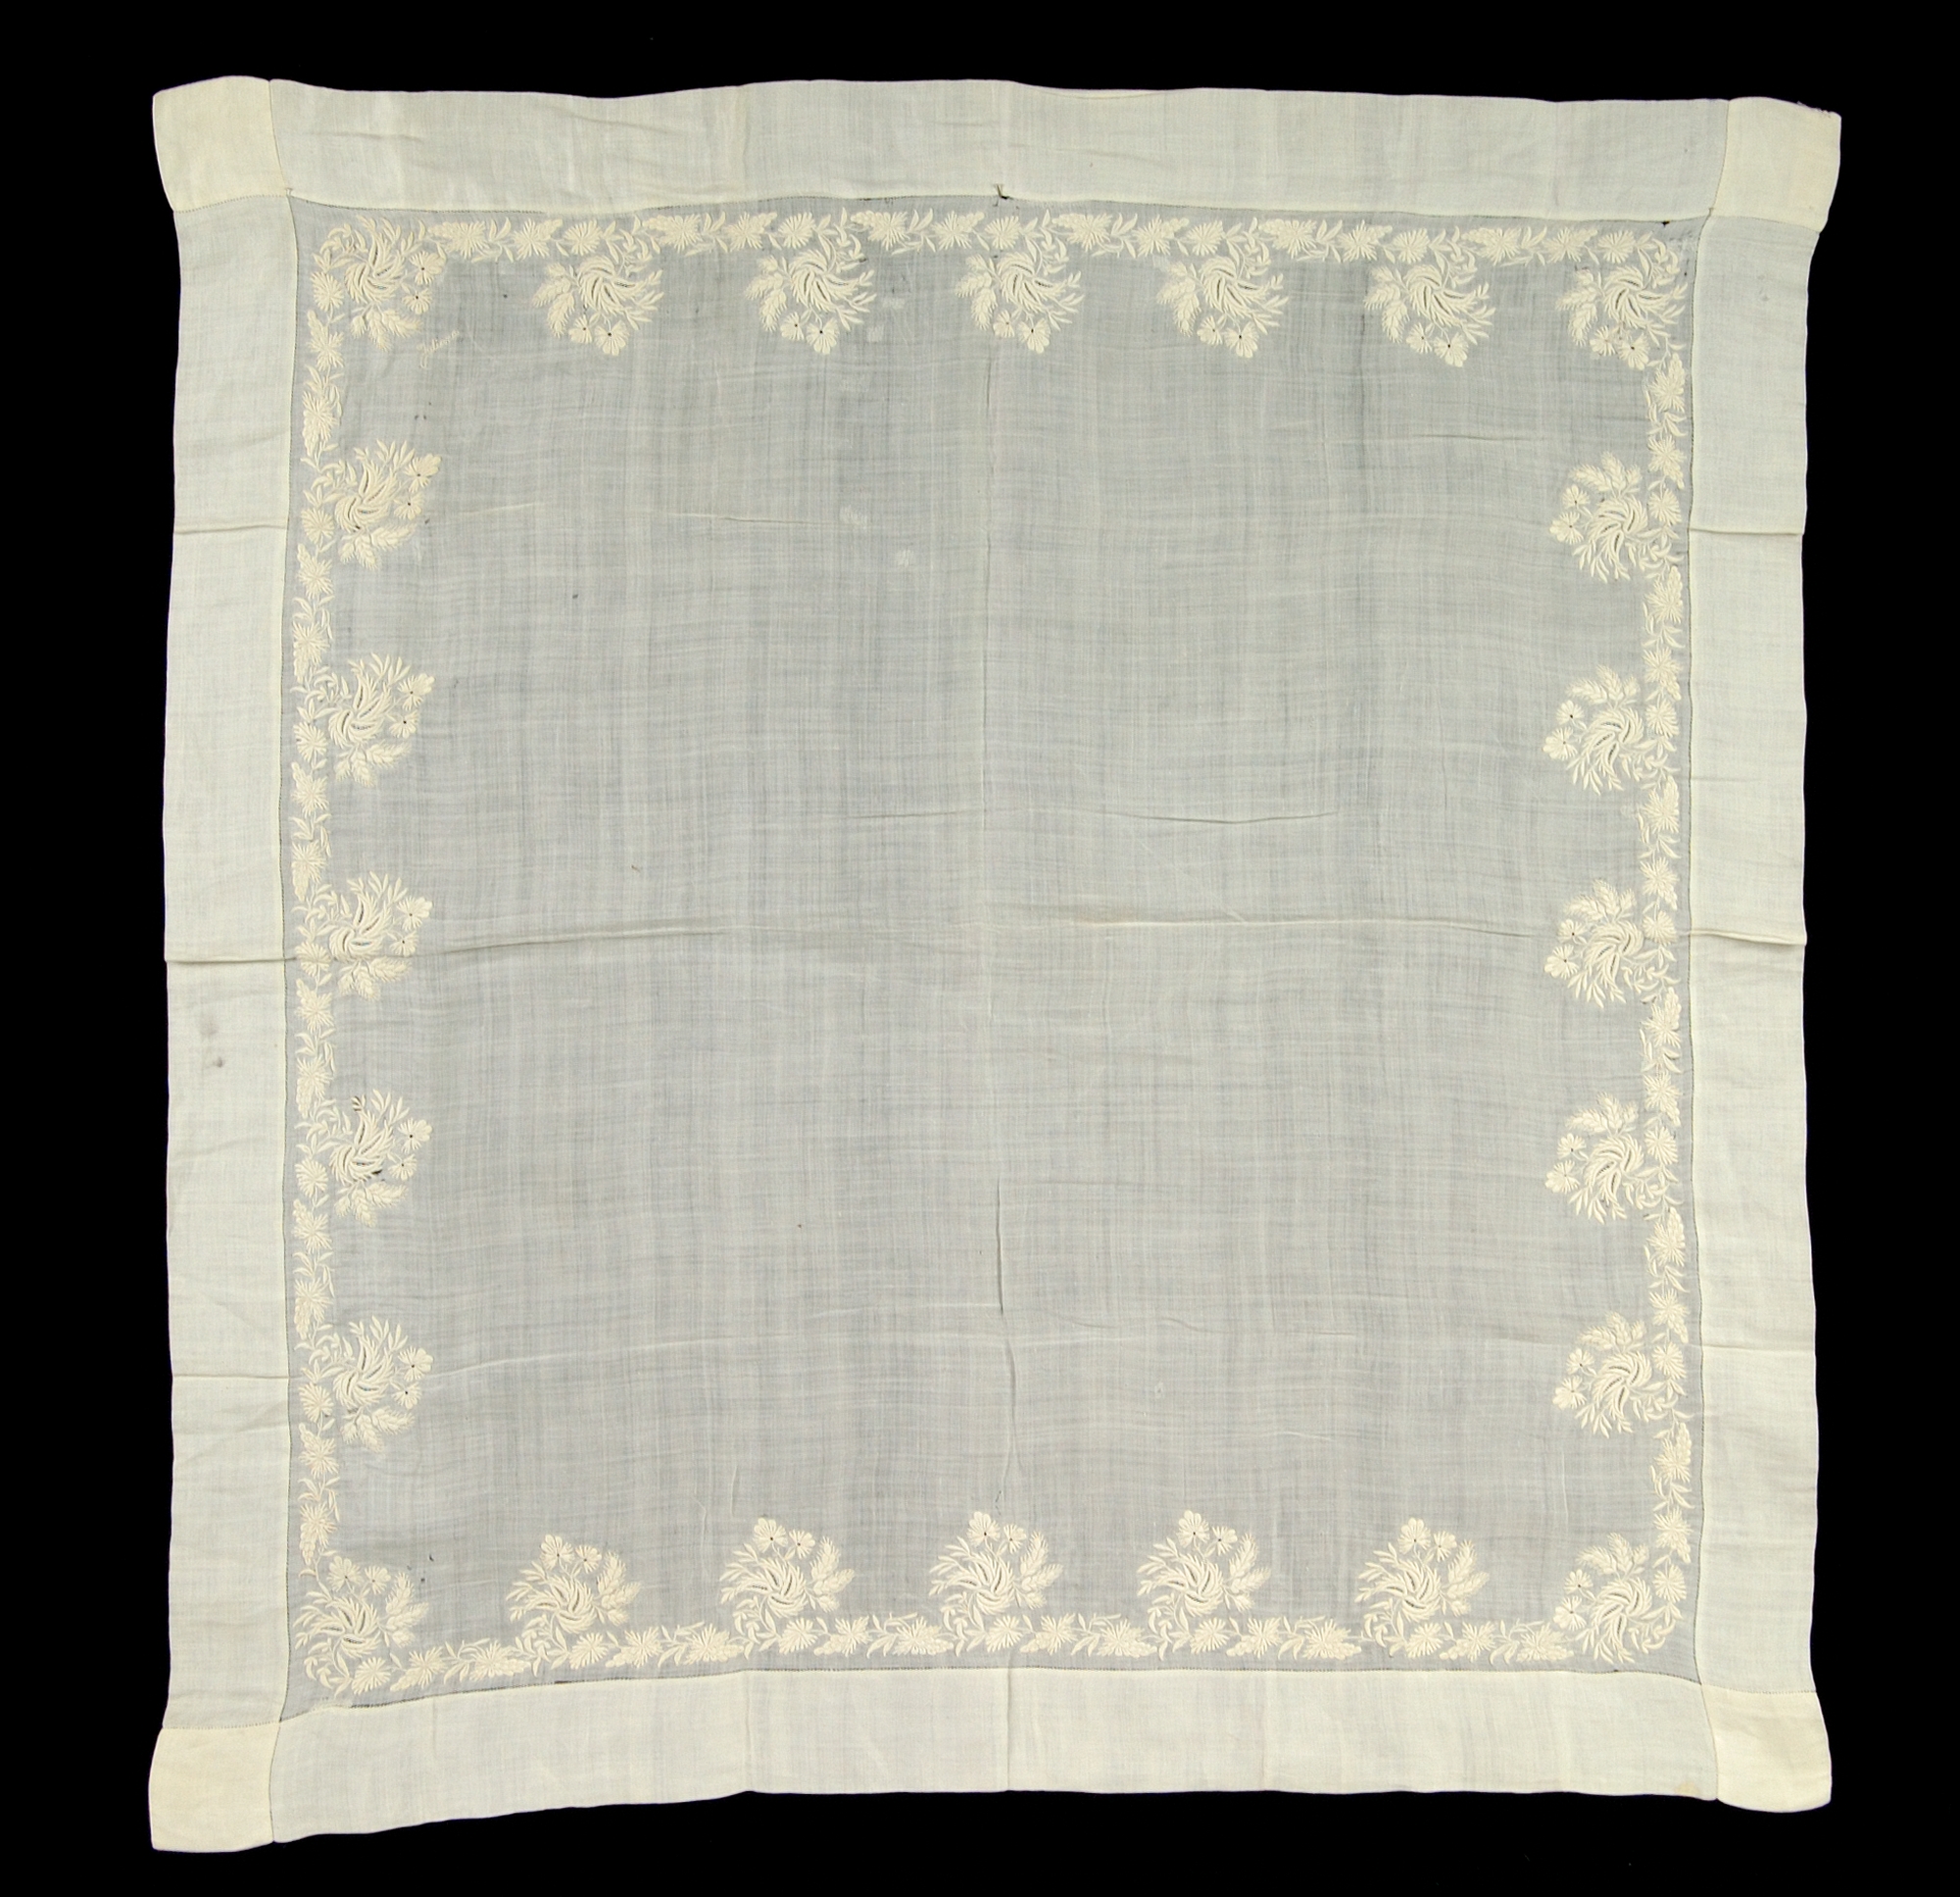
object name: handkerchief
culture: french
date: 1830-1850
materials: cotton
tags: flowers